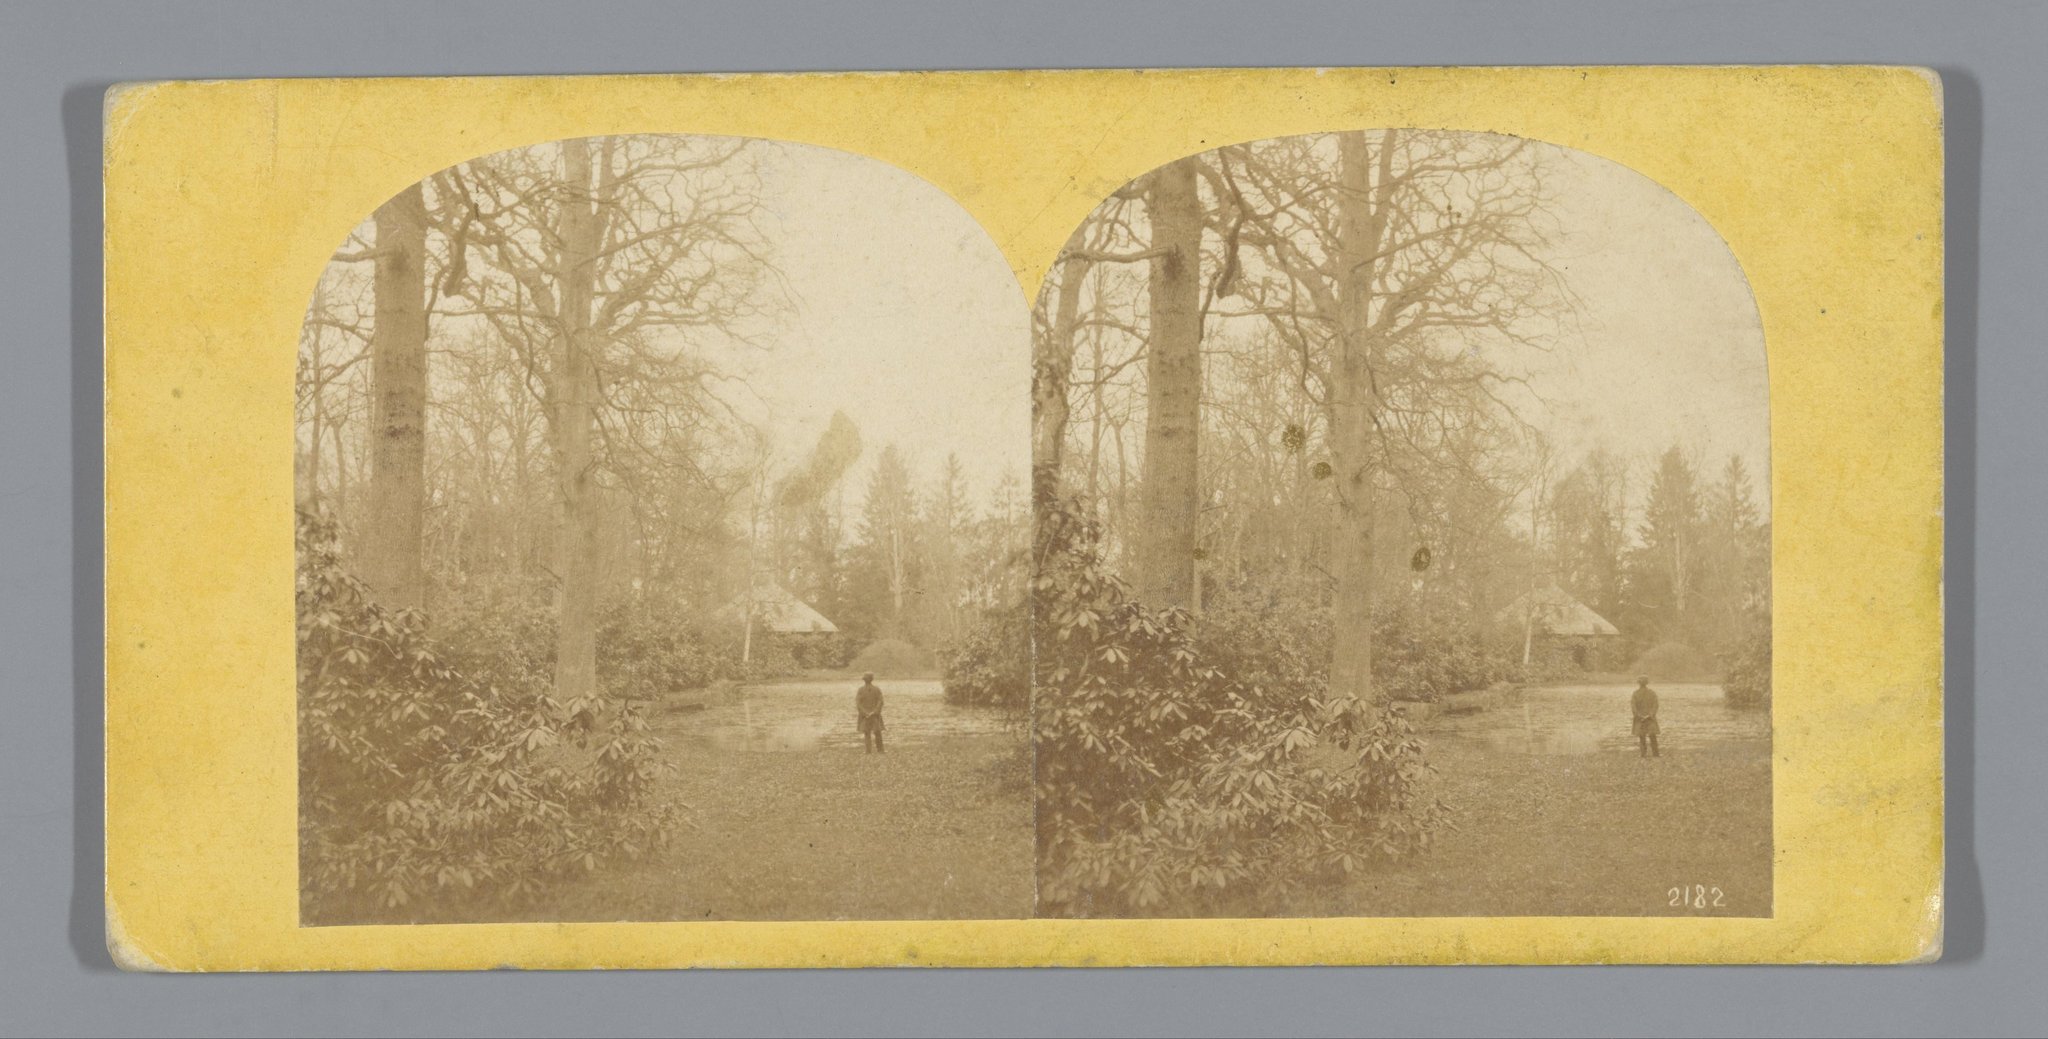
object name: stereograph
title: Man in een park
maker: Anonymous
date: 1861-1870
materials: cardboard, paper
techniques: albumen print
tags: park, enjoying nature, public gardens, park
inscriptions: number: ‘100’, number: ‘41’, number: ‘f1,00’